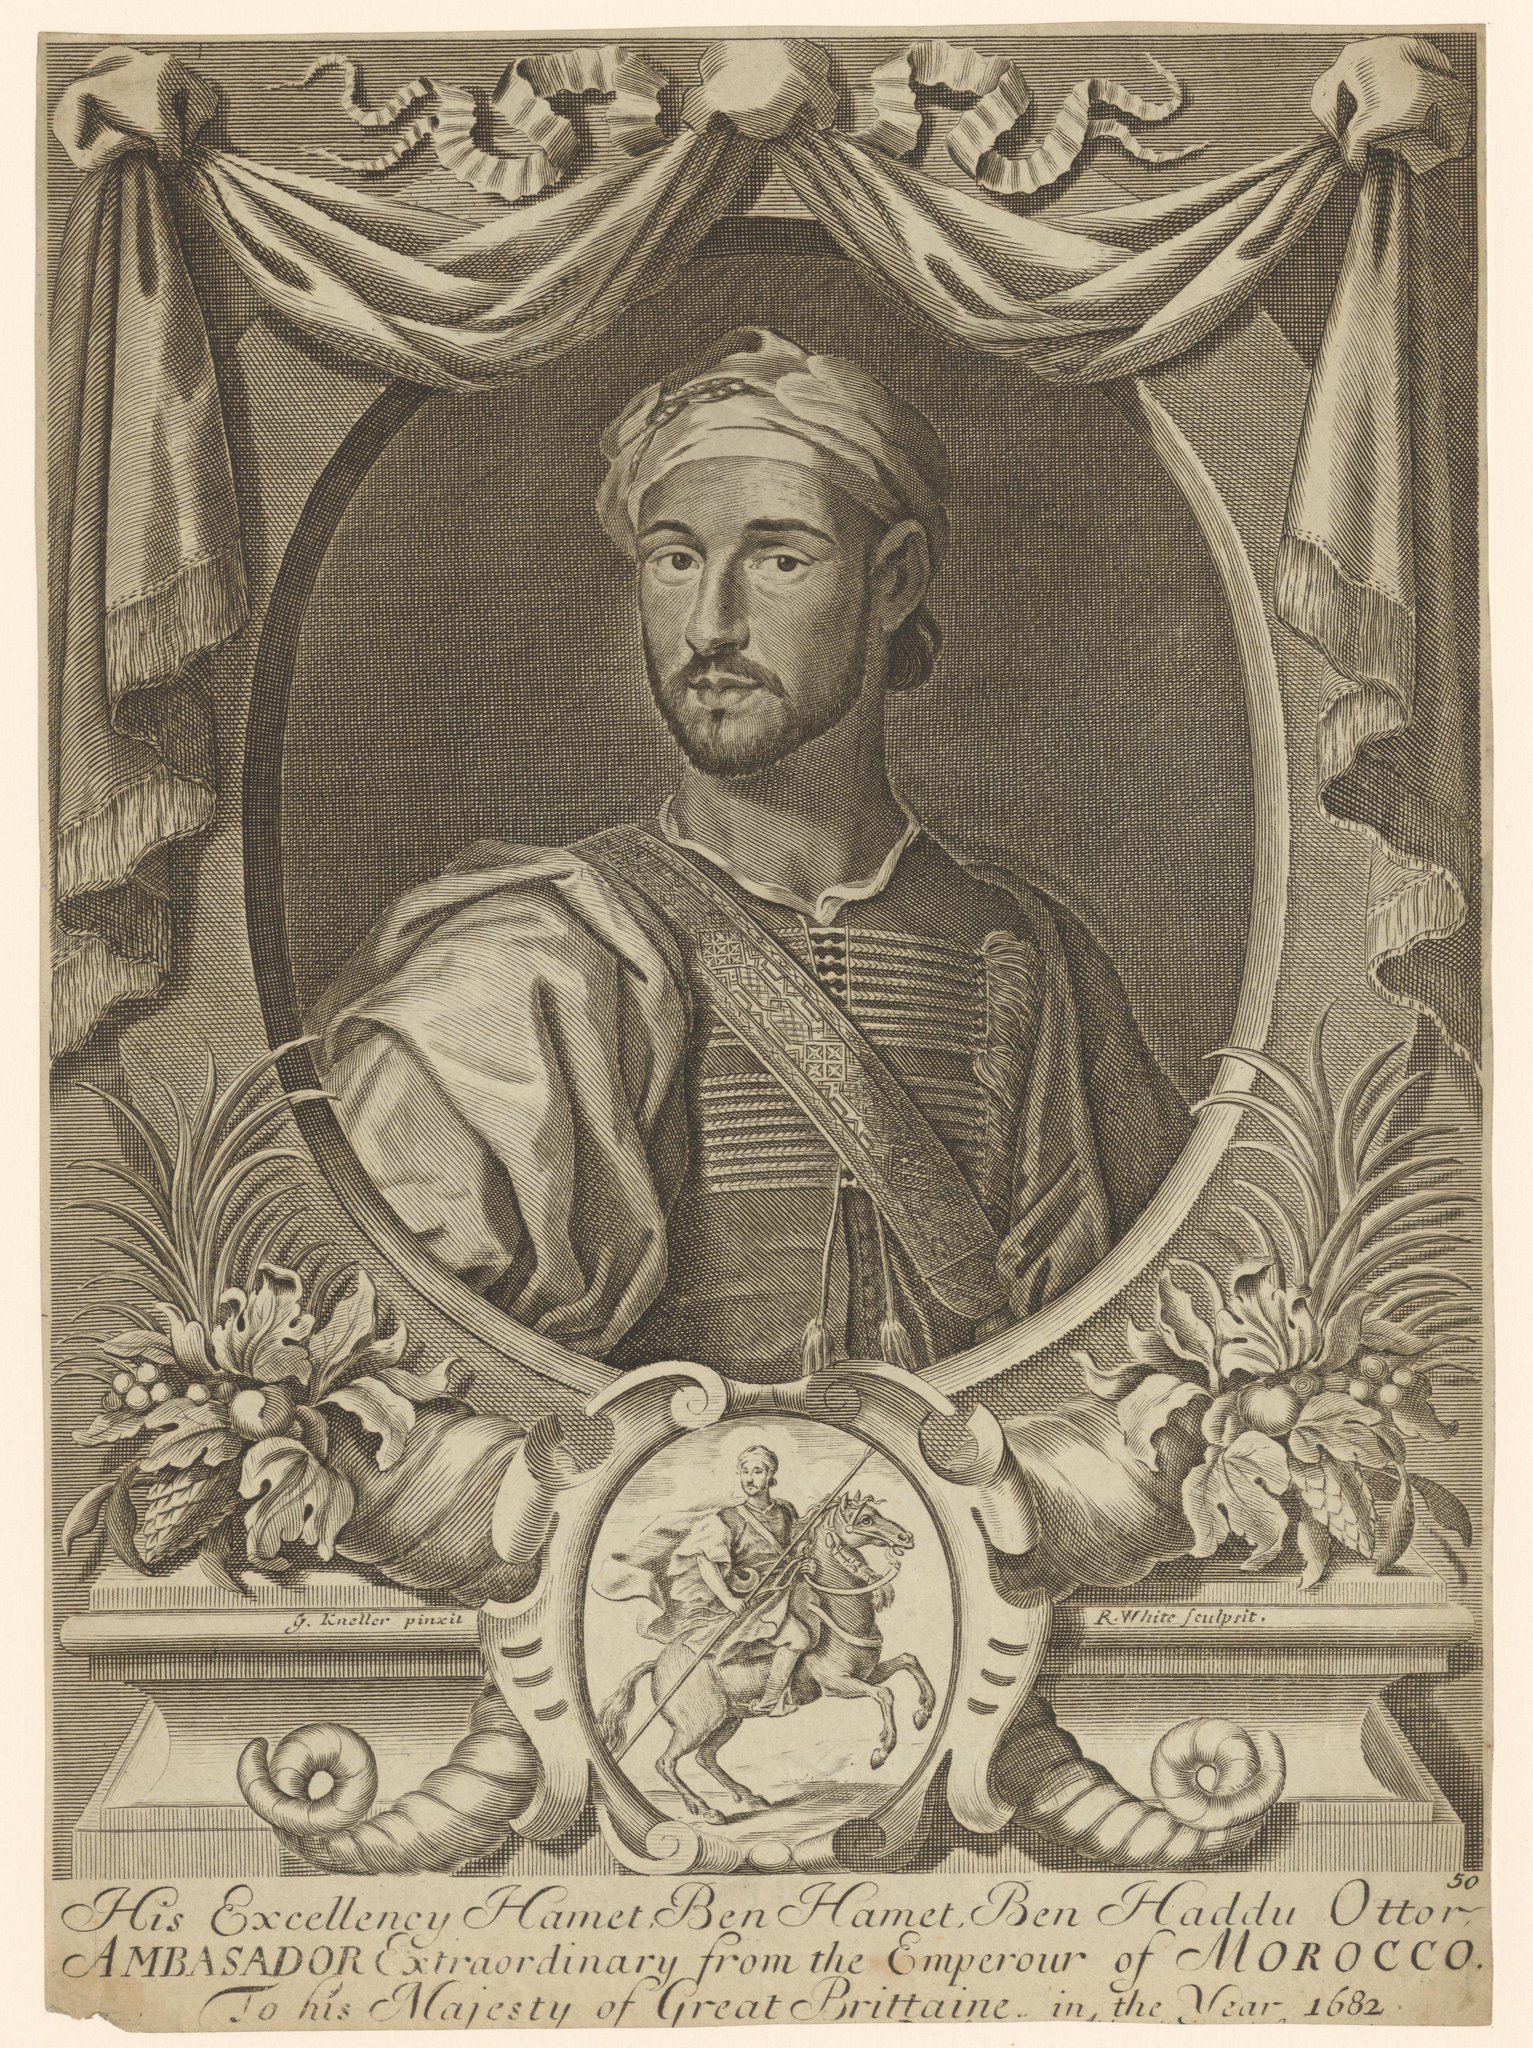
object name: print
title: Portret van Mohammed ben Hadou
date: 1682-1684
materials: paper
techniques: engraving, etching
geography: london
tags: historical persons, ambassador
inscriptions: collector's mark: Lugt 2228